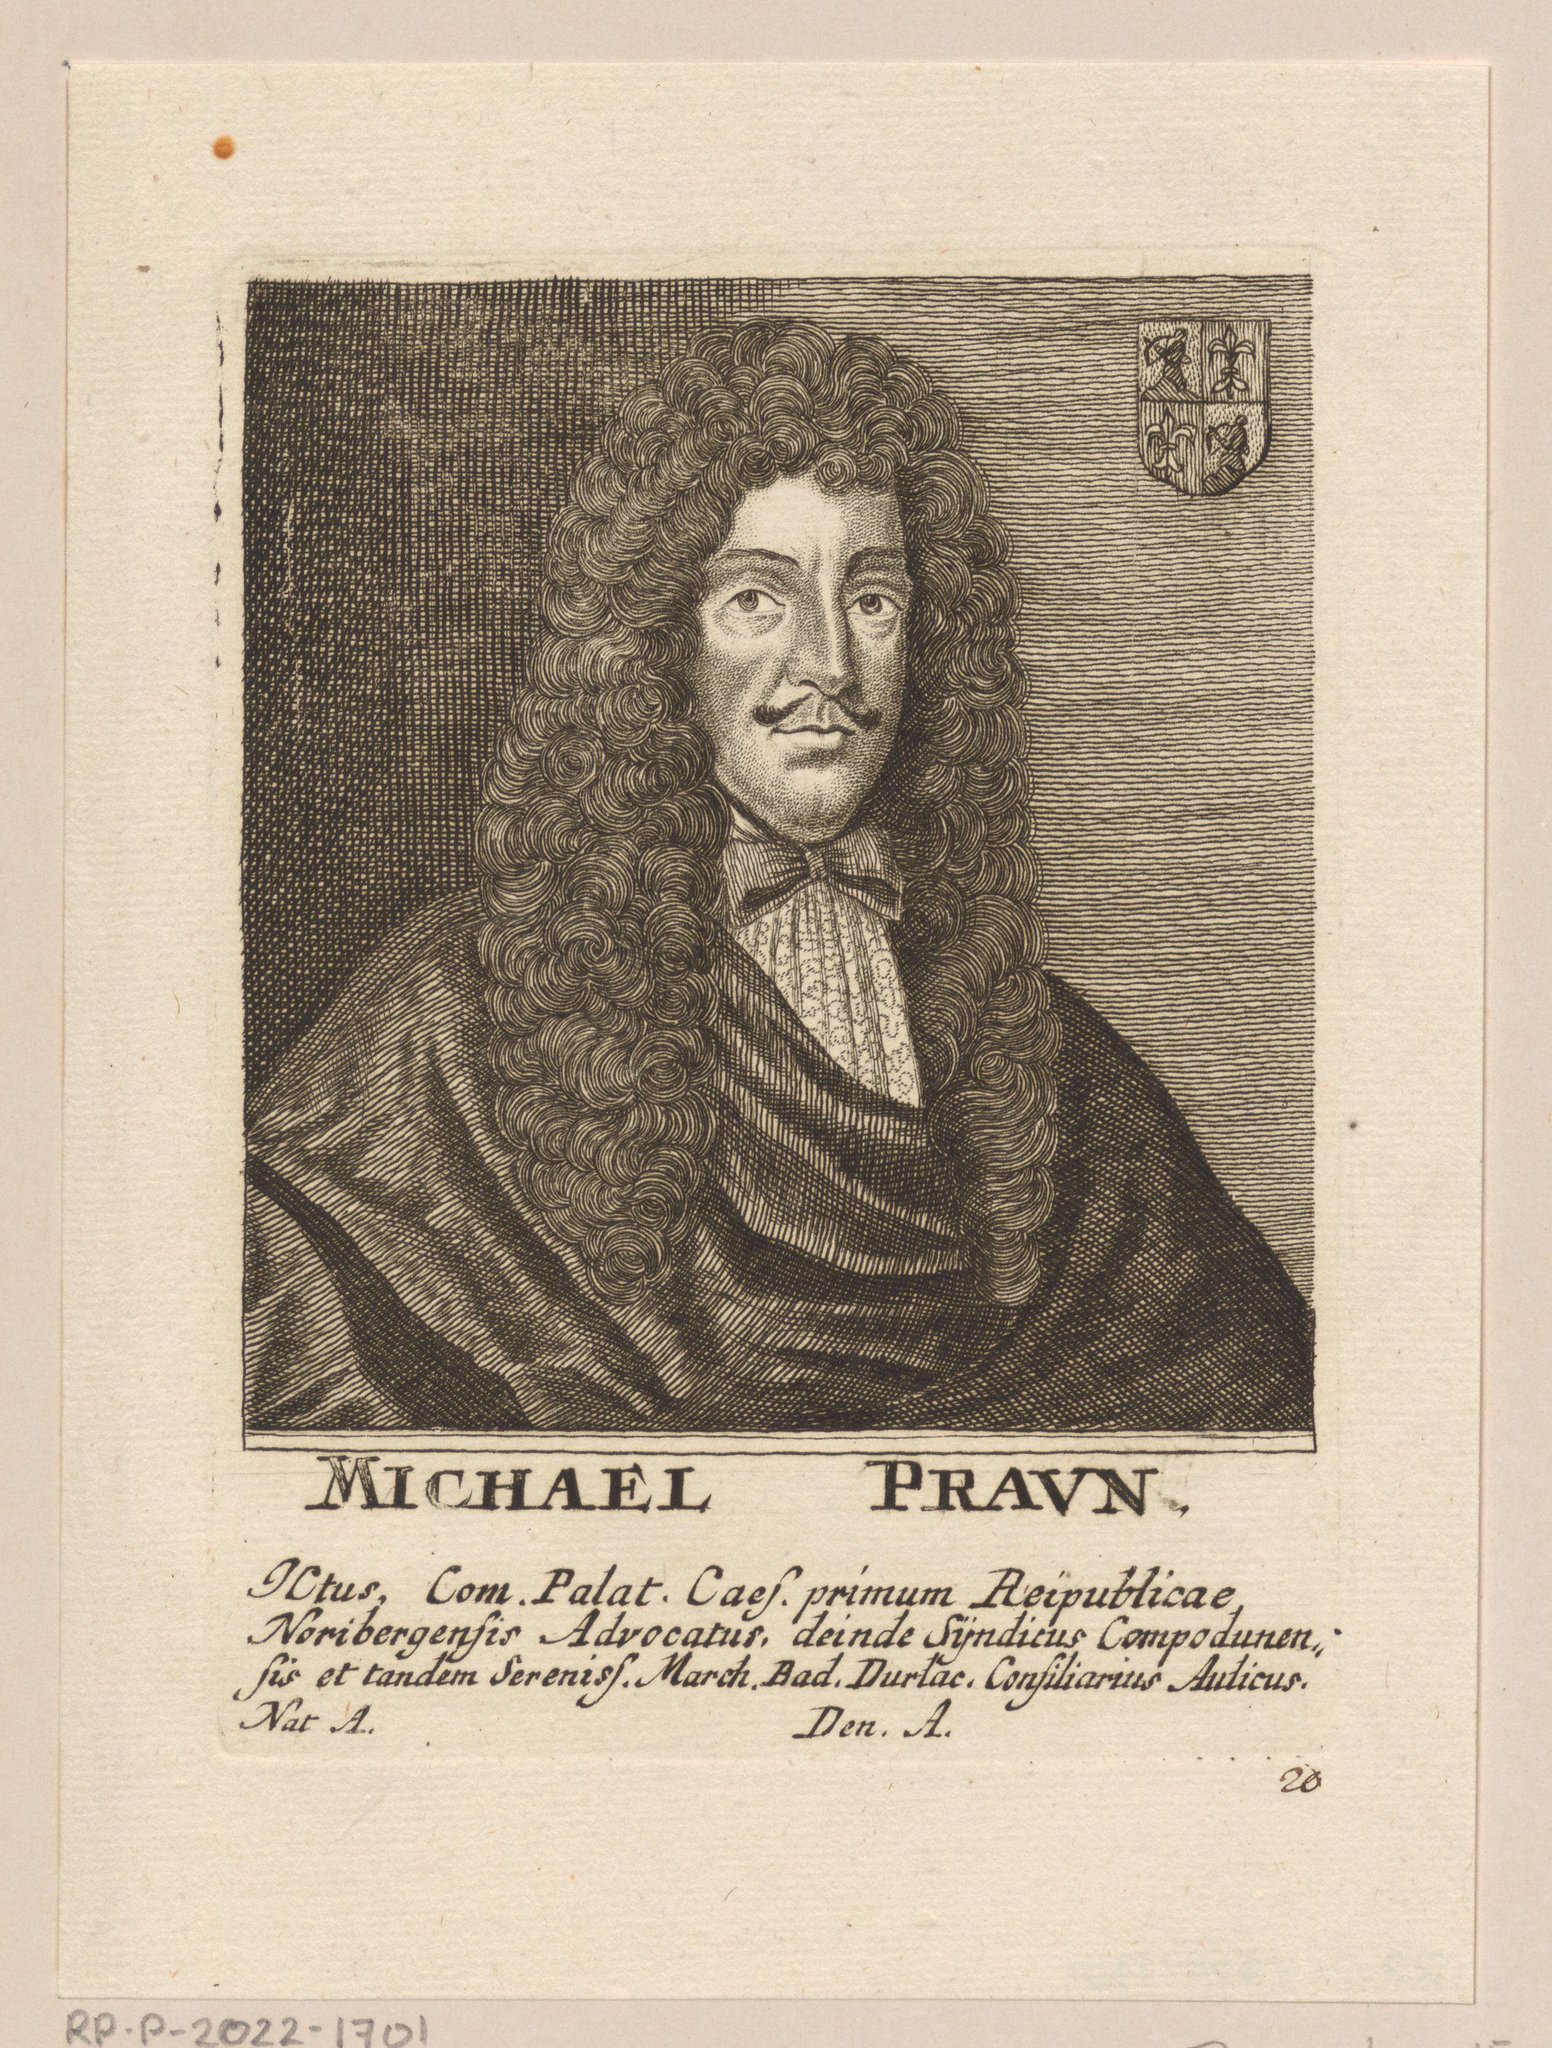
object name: print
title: Portret van Michael Praun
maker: Anonymous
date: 1725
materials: paper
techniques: engraving, etching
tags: historical persons, wig, armorial bearing, heraldry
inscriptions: number: ‘20’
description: Prent uit: Rothscholtz, Friedrich. Icones virorum omnium ordinum eruditione: omnique item genere et varietate artium de republica litteraria et speciatim de Academiis et Gymnasiis (...). Neurenberg: erven Johann Daniel Tauber, 1725, dl. 1 of 2.